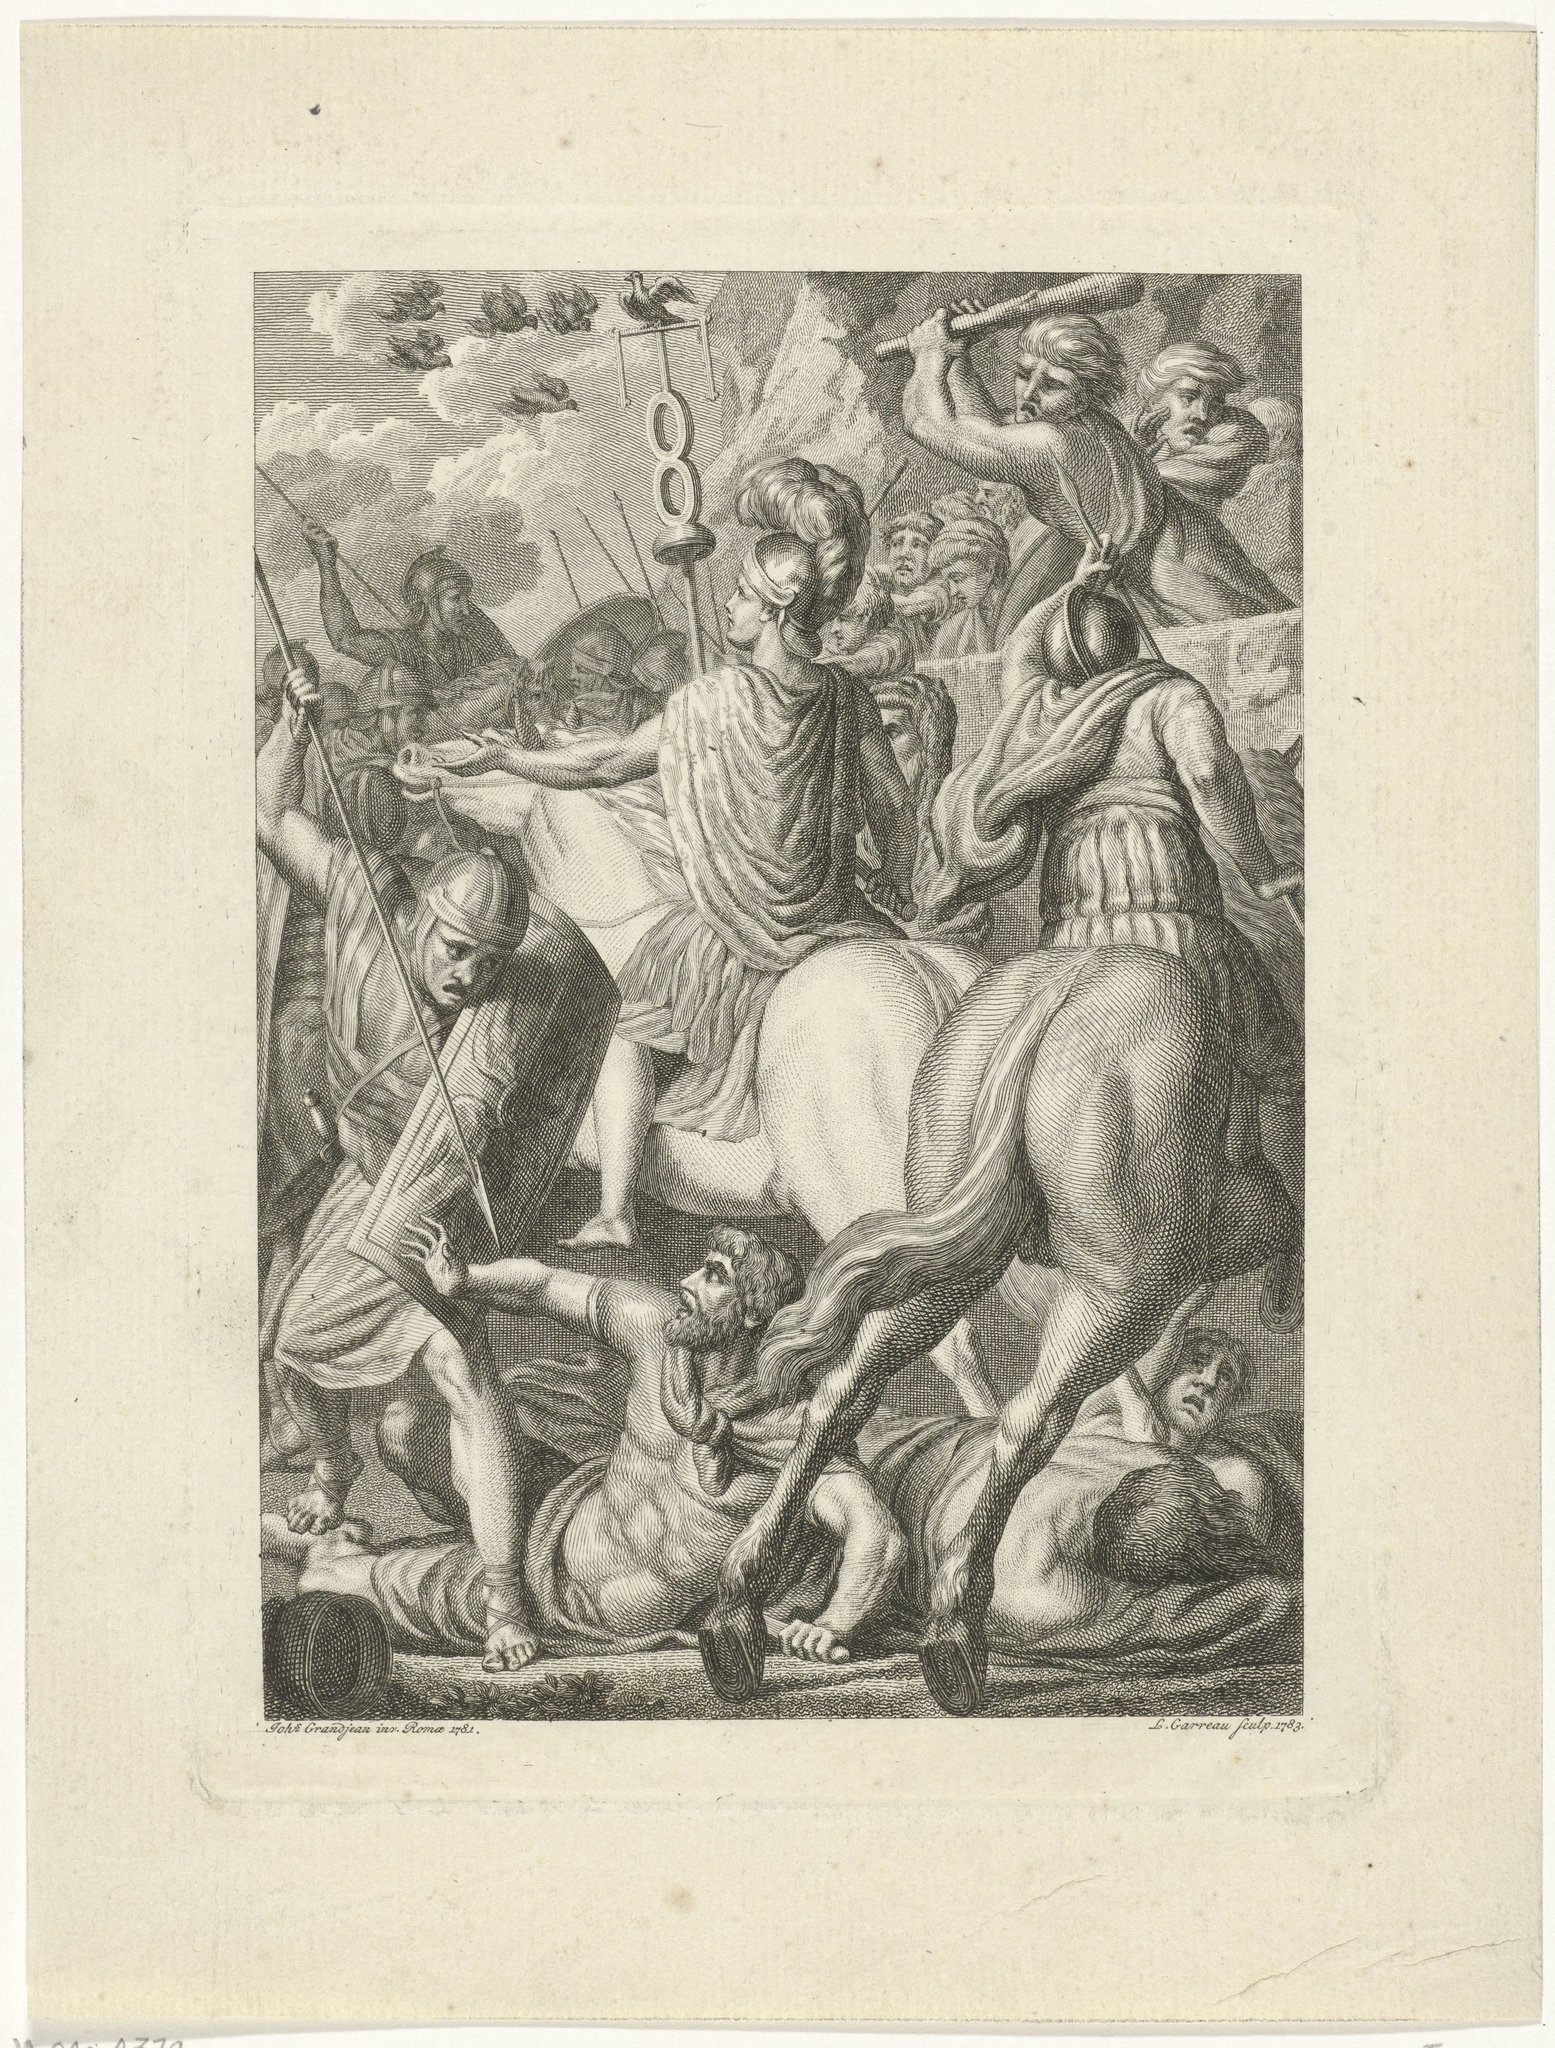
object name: print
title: Germanicus tijdens een veldslag met Germanen.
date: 1783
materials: paper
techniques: engraving, etching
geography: amsterdam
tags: predatory birds: eagle, battle, europeans: germans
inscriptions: collector's mark: Lugt 2228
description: Germanicus ziet tijdens een veldslag zes adelaars in de lucht. Hij geeft het bevel de adelaars te volgen. Aldus verhindert hij een hinderlaag die de Germanen hadden gepland. Het Romeinse leger verplettert vervolgens de Germaanse tegenstand. De prent is een deel van de geschiedenis van generaal Germanicus.